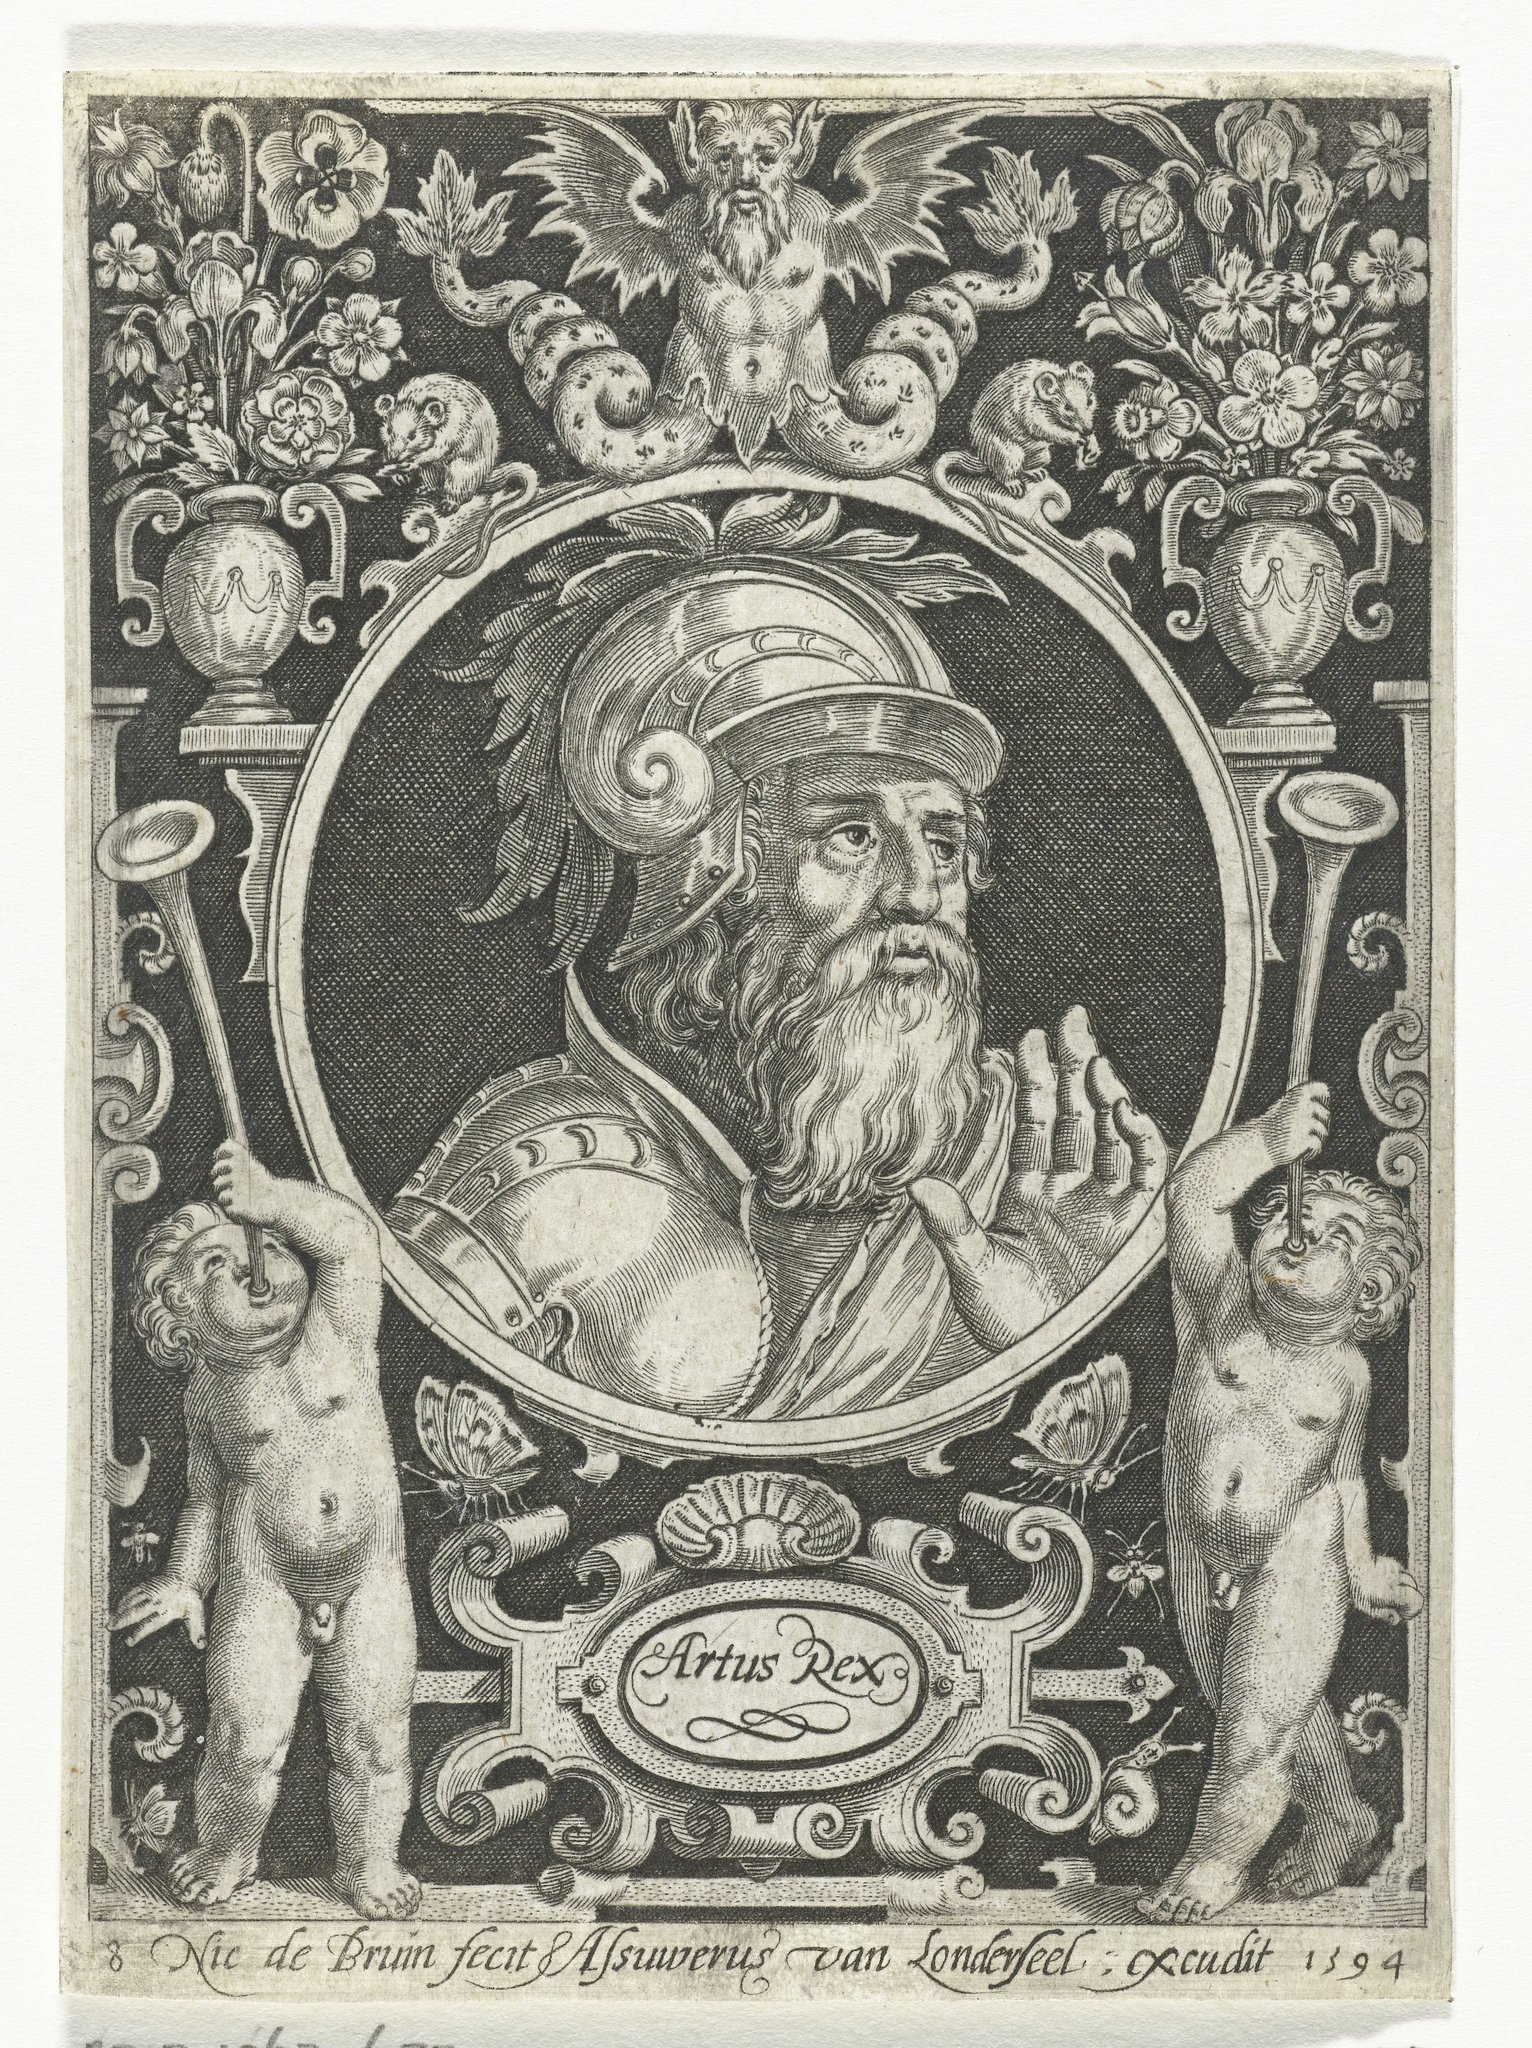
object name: print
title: Artus Rex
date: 1594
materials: paper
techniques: engraving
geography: netherlands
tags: arthur (one of the nine worthies)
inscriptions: collector's mark: Lugt 2228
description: Portret van koning Arthur met helm en harnas in medaillon binnen rechthoekige omlijsting met ornamenten zoals twee kinderen die op een trompet blazen en vazen met bloemen.